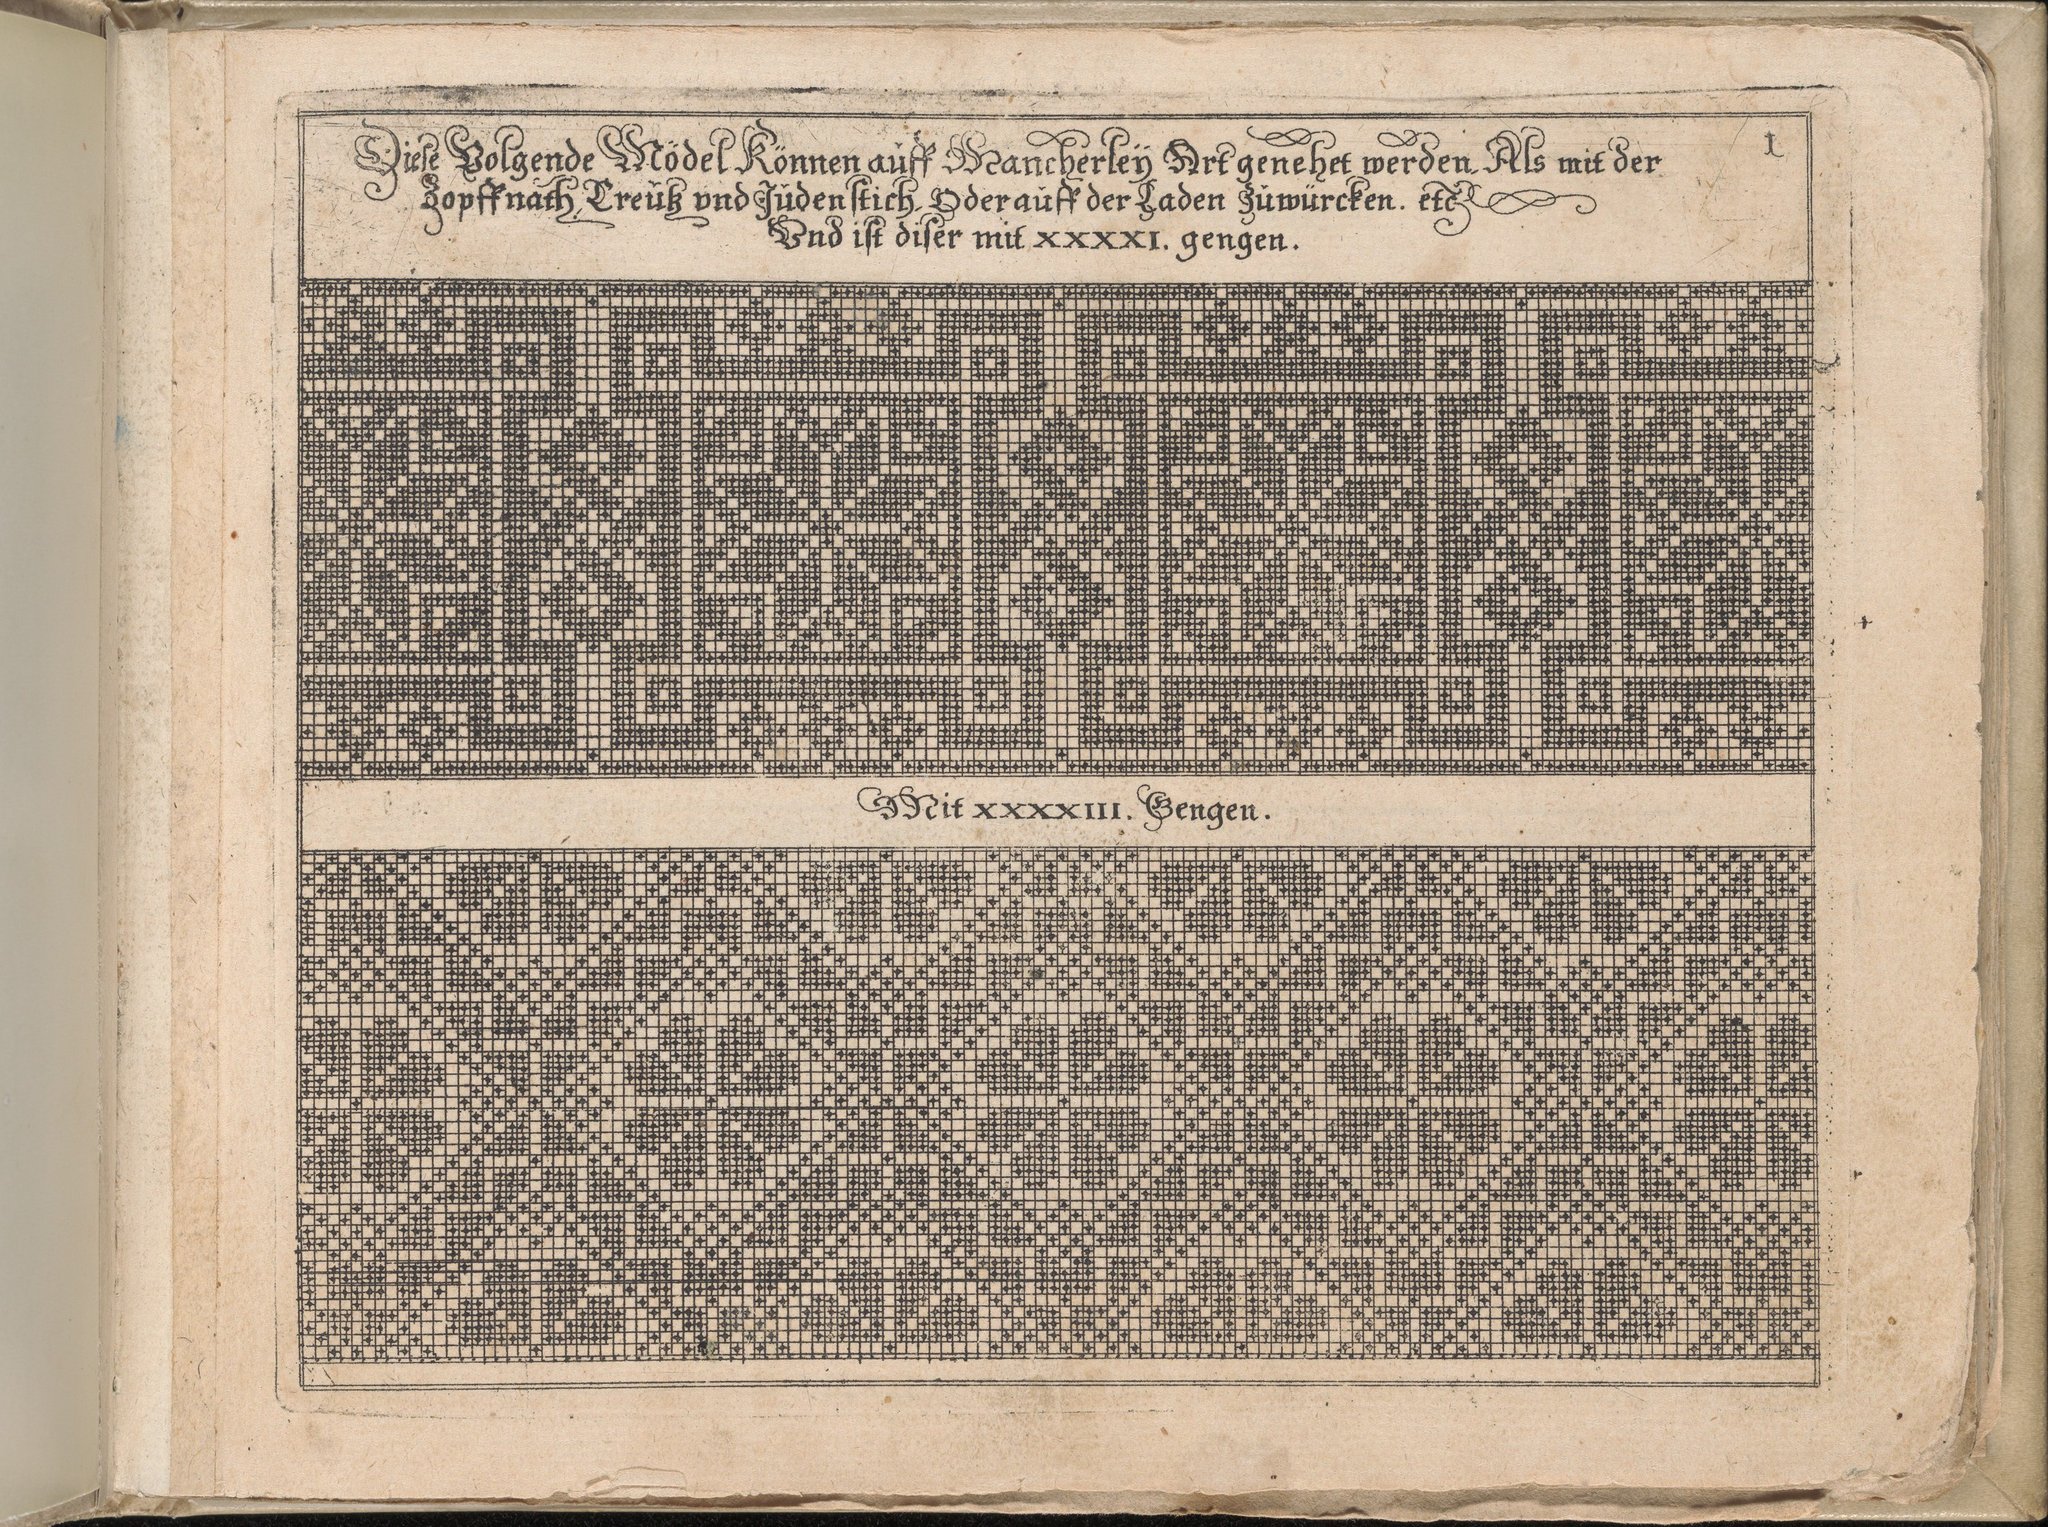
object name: book print ornament architecture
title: Schön Neues Modelbuch (Page 6 recto)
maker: johann sibmacher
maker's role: designer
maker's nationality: german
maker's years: 1590-1611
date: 1597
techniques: etching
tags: ornament